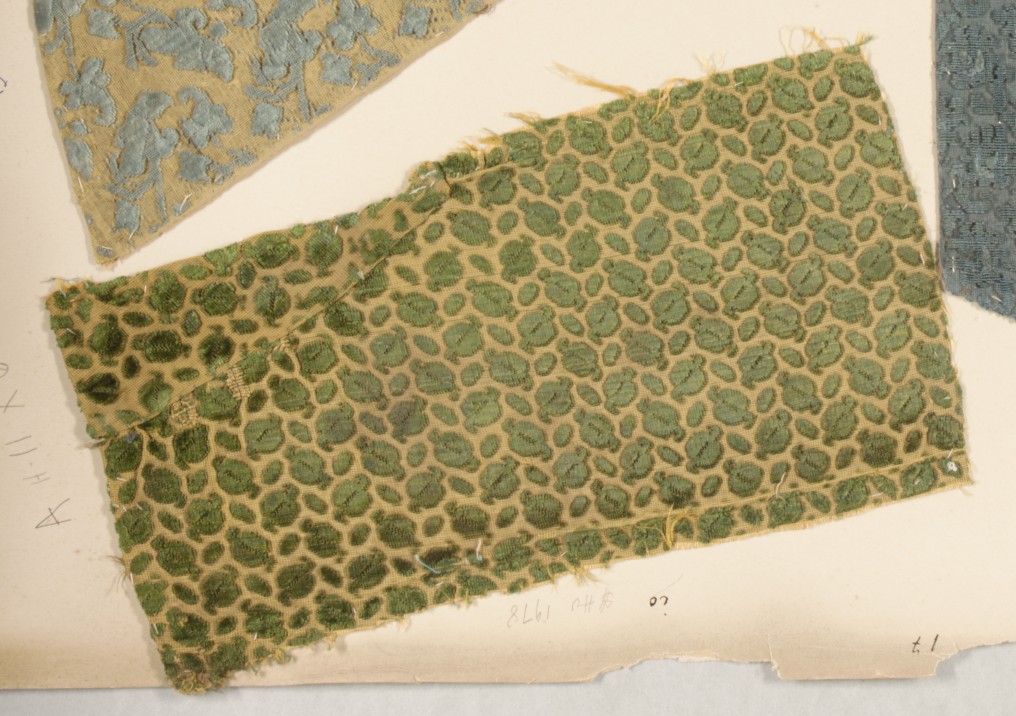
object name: fragment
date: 1501-1533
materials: silk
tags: flowers